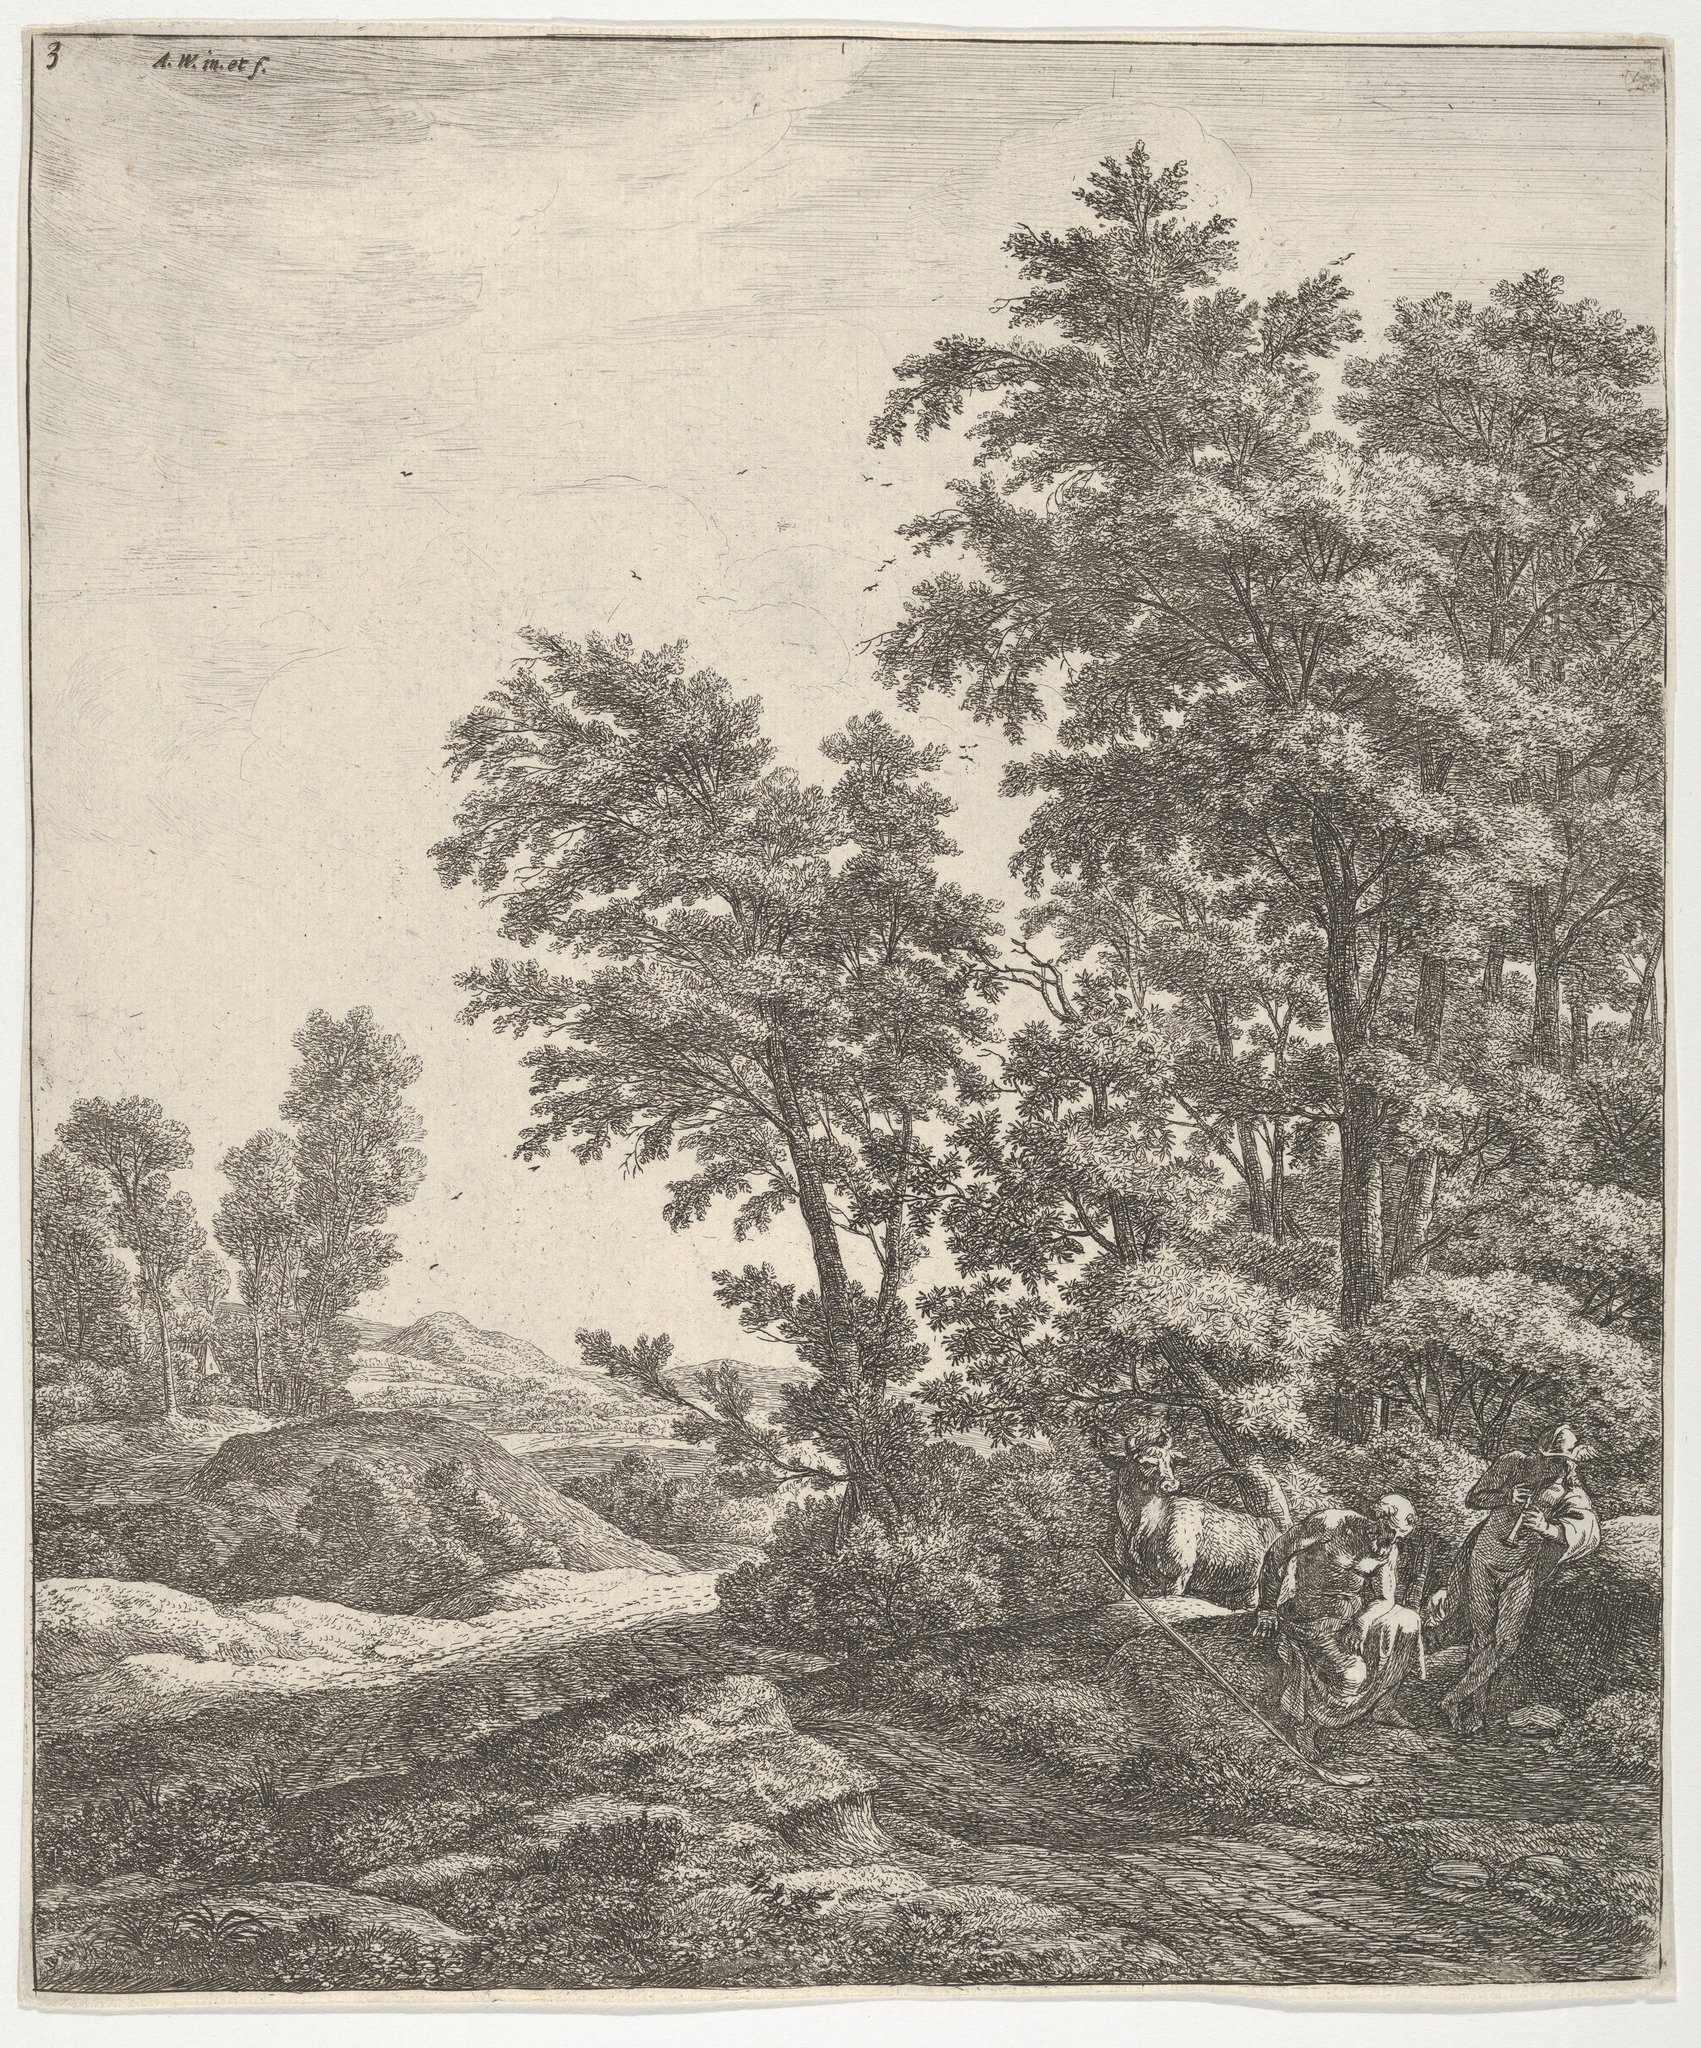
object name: print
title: Landscape with Mercury and Argus, from the Series of Six Mythological Scenes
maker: anthonie waterloo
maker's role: artist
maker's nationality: dutch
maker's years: 1609-1690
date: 1601-1700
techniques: etching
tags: mercury,landscapes